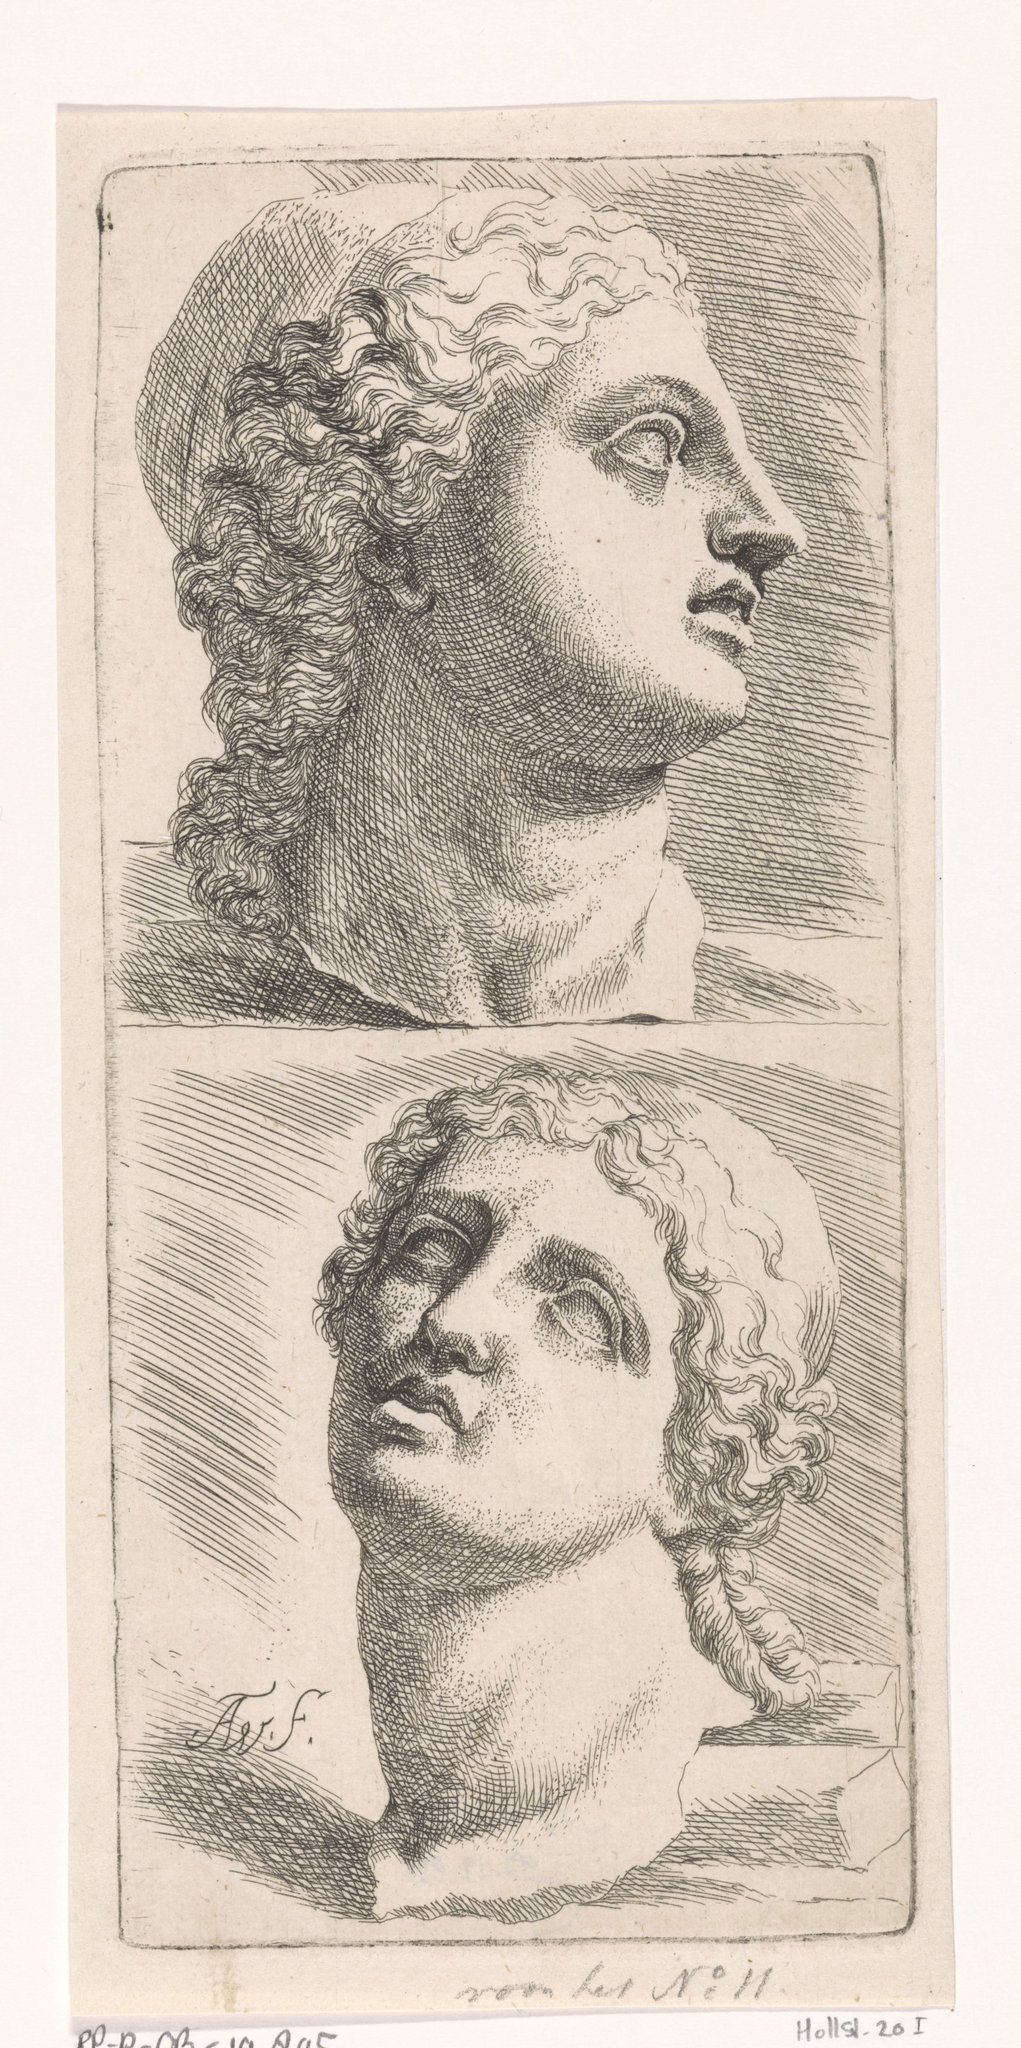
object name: print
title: Studies voor een tekeningenboek naar klassieke sculpturen en figuren van Anthony van Dyck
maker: augustinus terwesten (i)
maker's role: draughtsman, painter, print maker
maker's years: 1649-1711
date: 1672-1711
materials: paper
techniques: etching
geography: rome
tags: piece of sculpture, reproduction of a piece of sculpture, (story of) niobe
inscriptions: collector's mark: Lugt 2228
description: Boven en onder twee aanzichten van een klassieke sculptuur van het hoofd van Niobe.